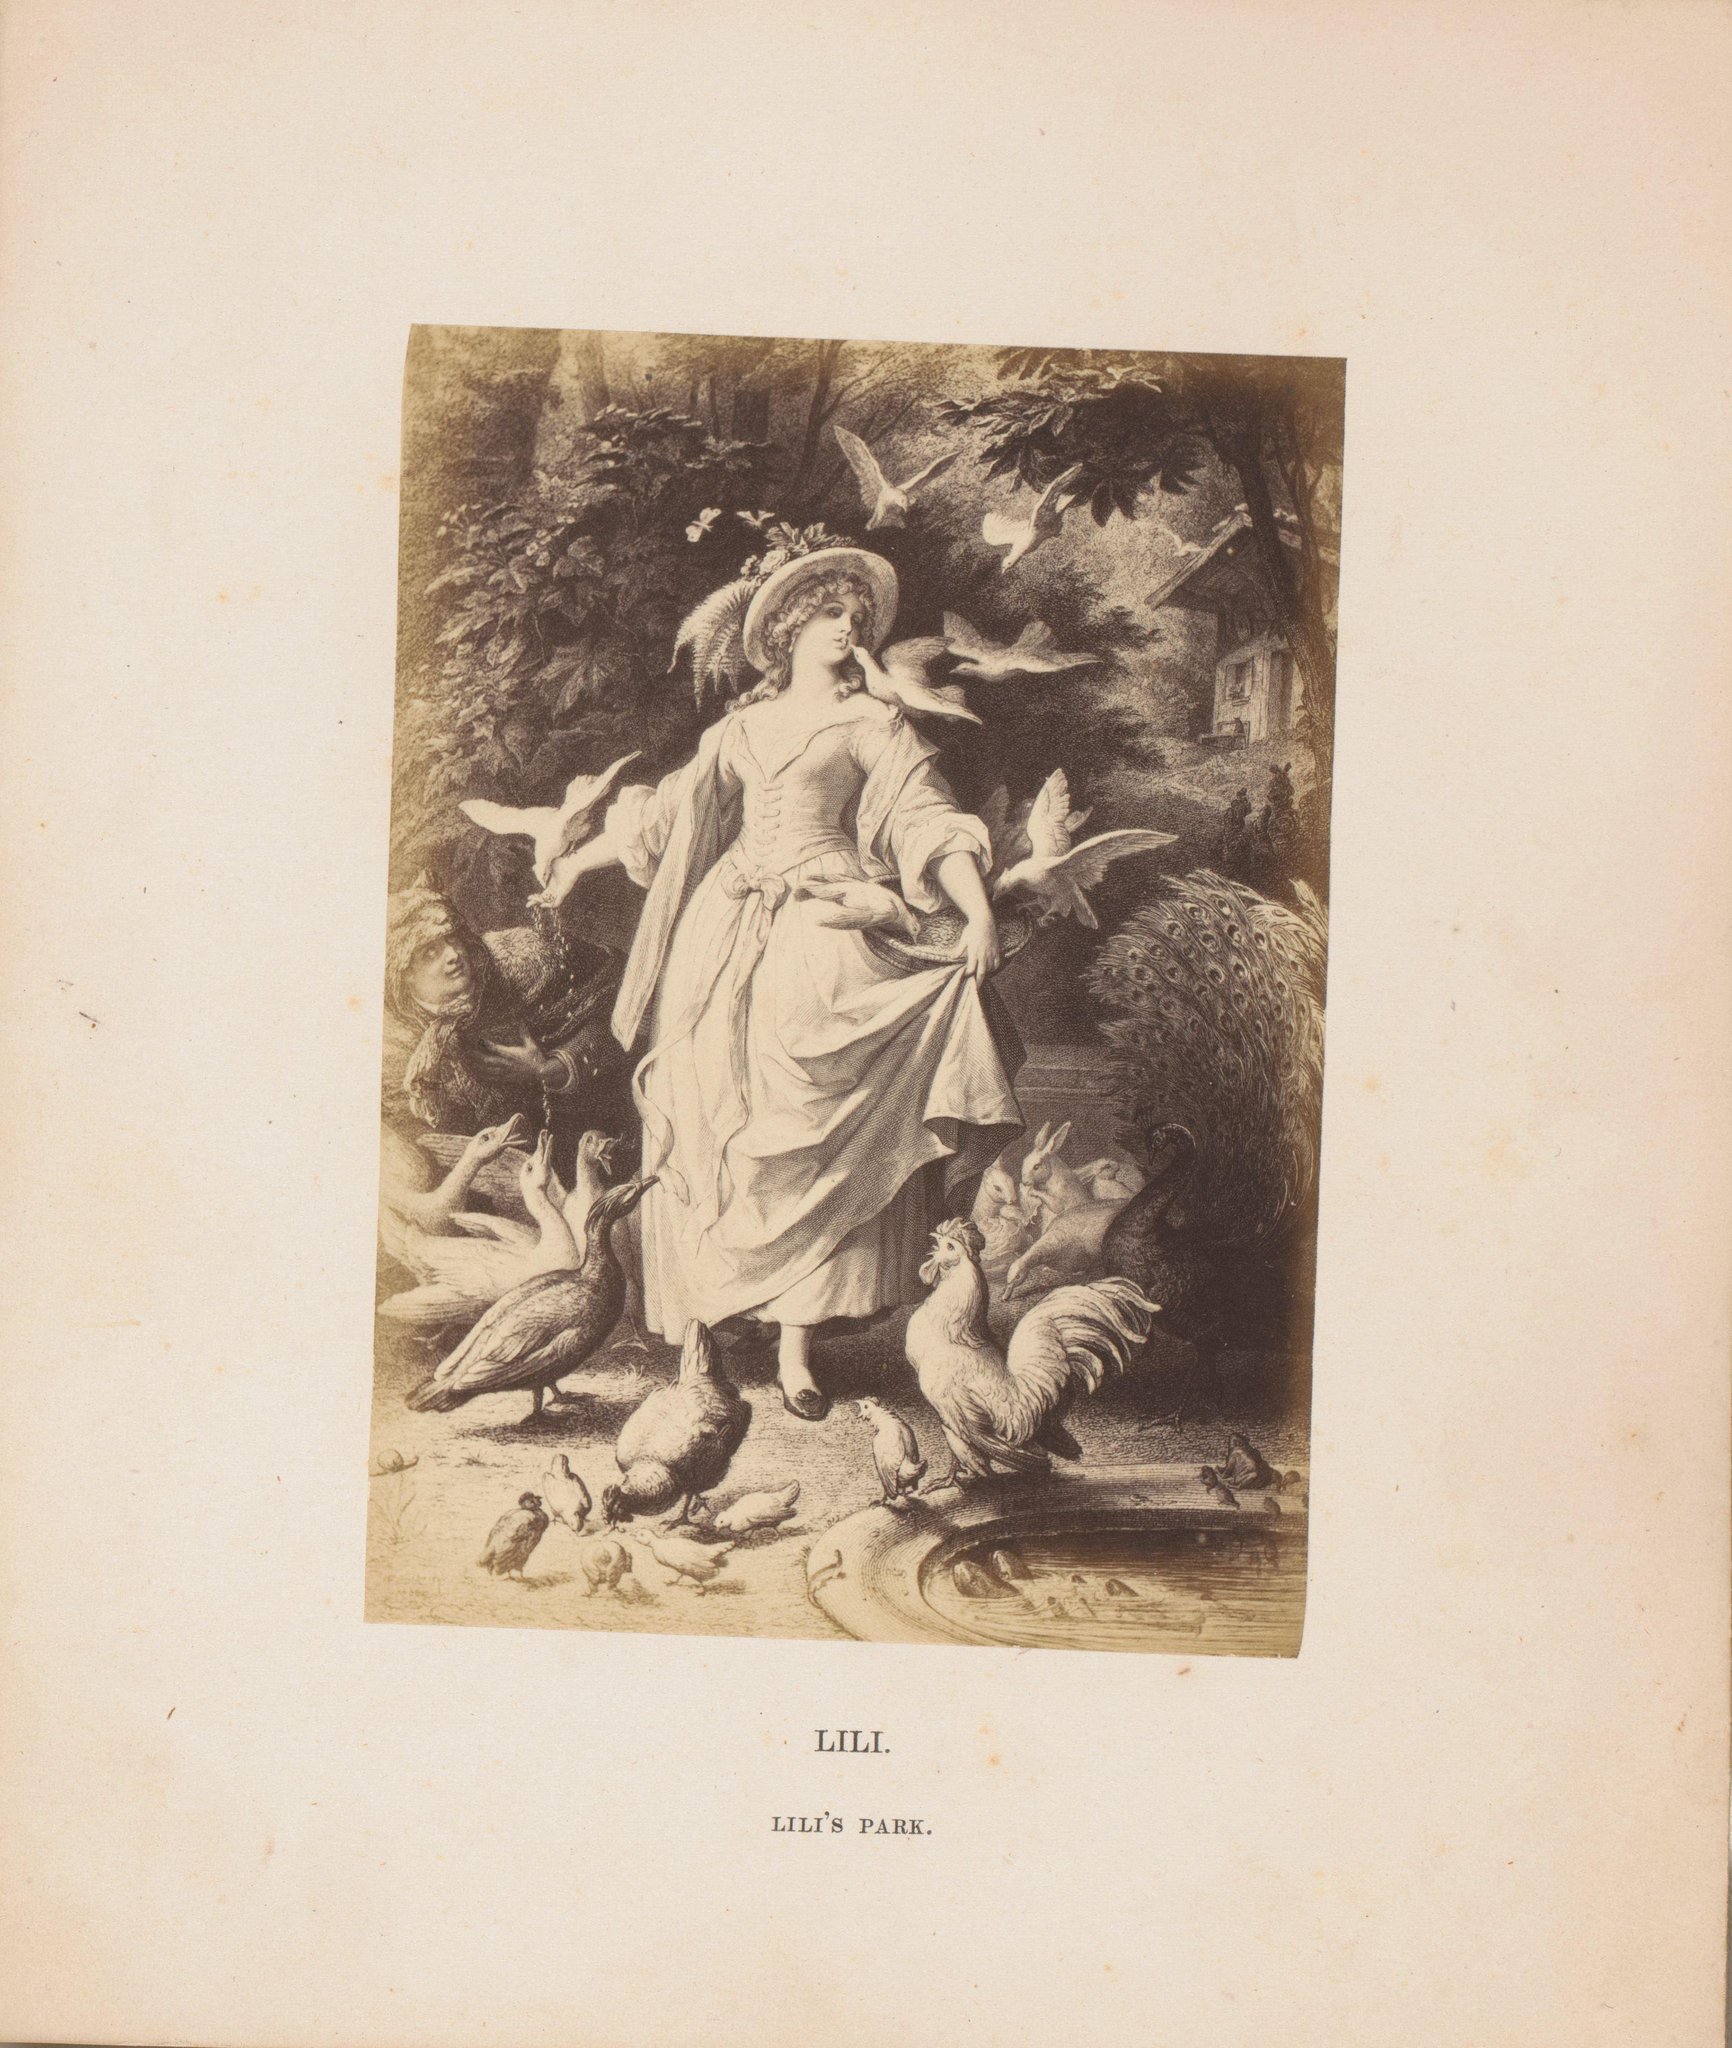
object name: reproduction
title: Fotoreproductie van een tekening van Lili uit Goethe's Lili's Park door Wilhelm von Kaulbach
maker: Anonymous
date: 1850-1900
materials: cardboard, photographic support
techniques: albumen print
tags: park, adult woman, specific works of literature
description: Deze foto maakt deel uit van een omslag met 22 foto's.